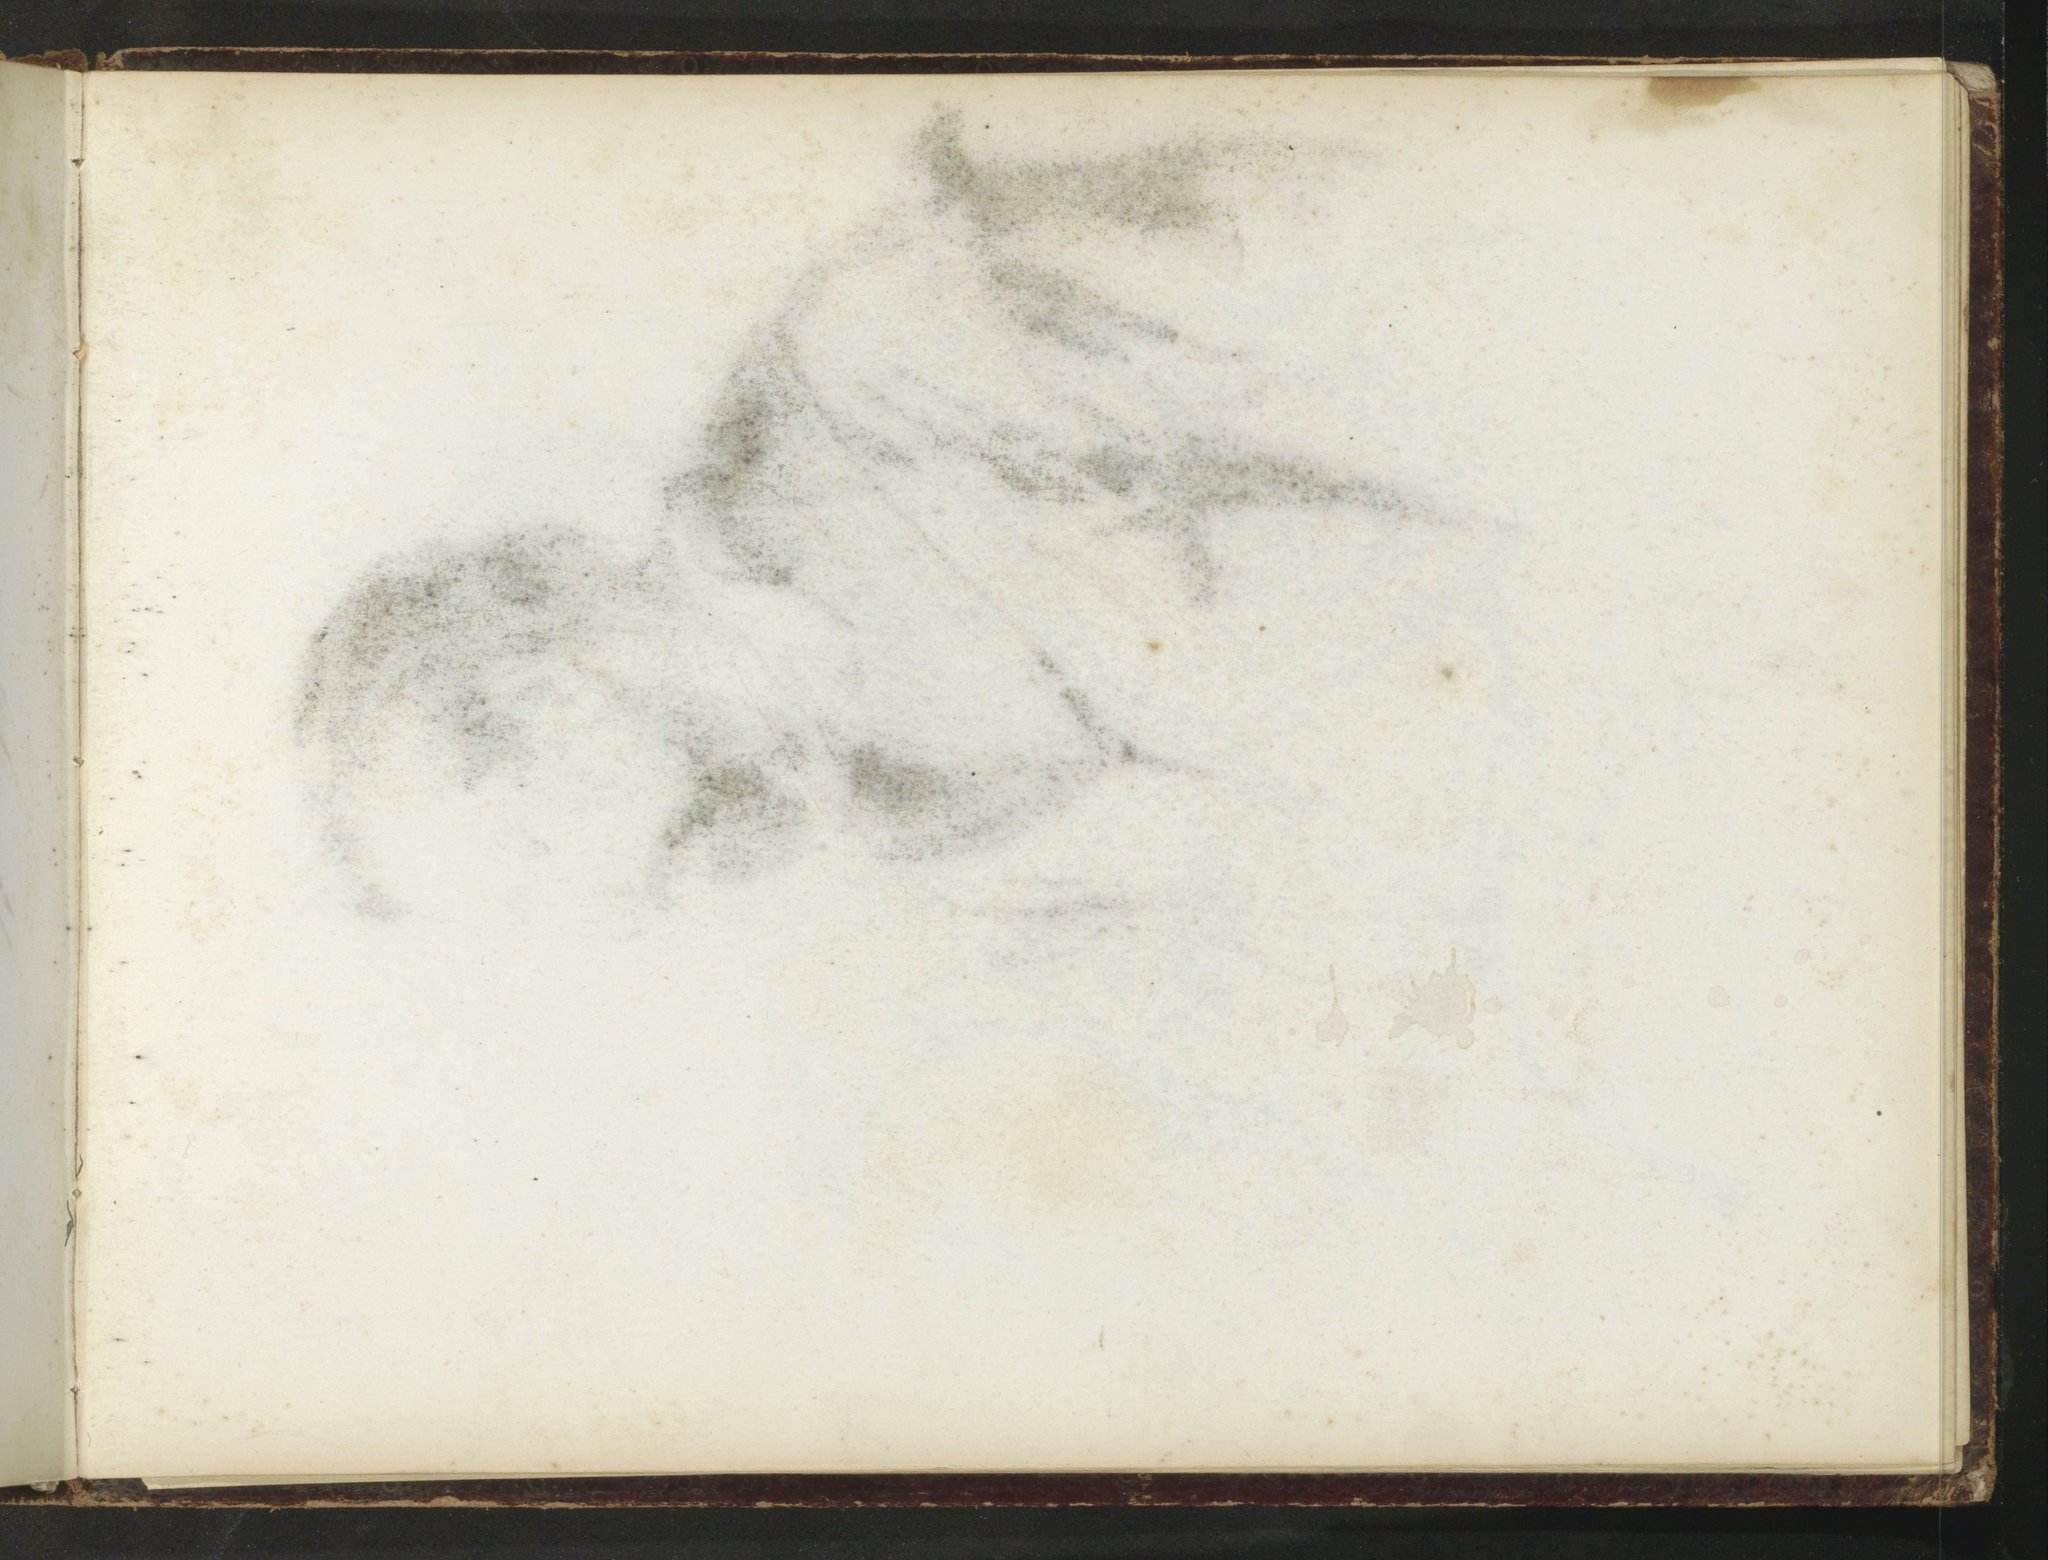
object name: sketchbook leaf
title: Abklatsch van de houtskooltekening op blad 39 verso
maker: reinier craeyvanger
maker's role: draughtsman, print maker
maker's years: 1812-1880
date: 1822-1880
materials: paper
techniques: printmaking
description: Blad 40 recto uit een schetsboek met 45 bladen.